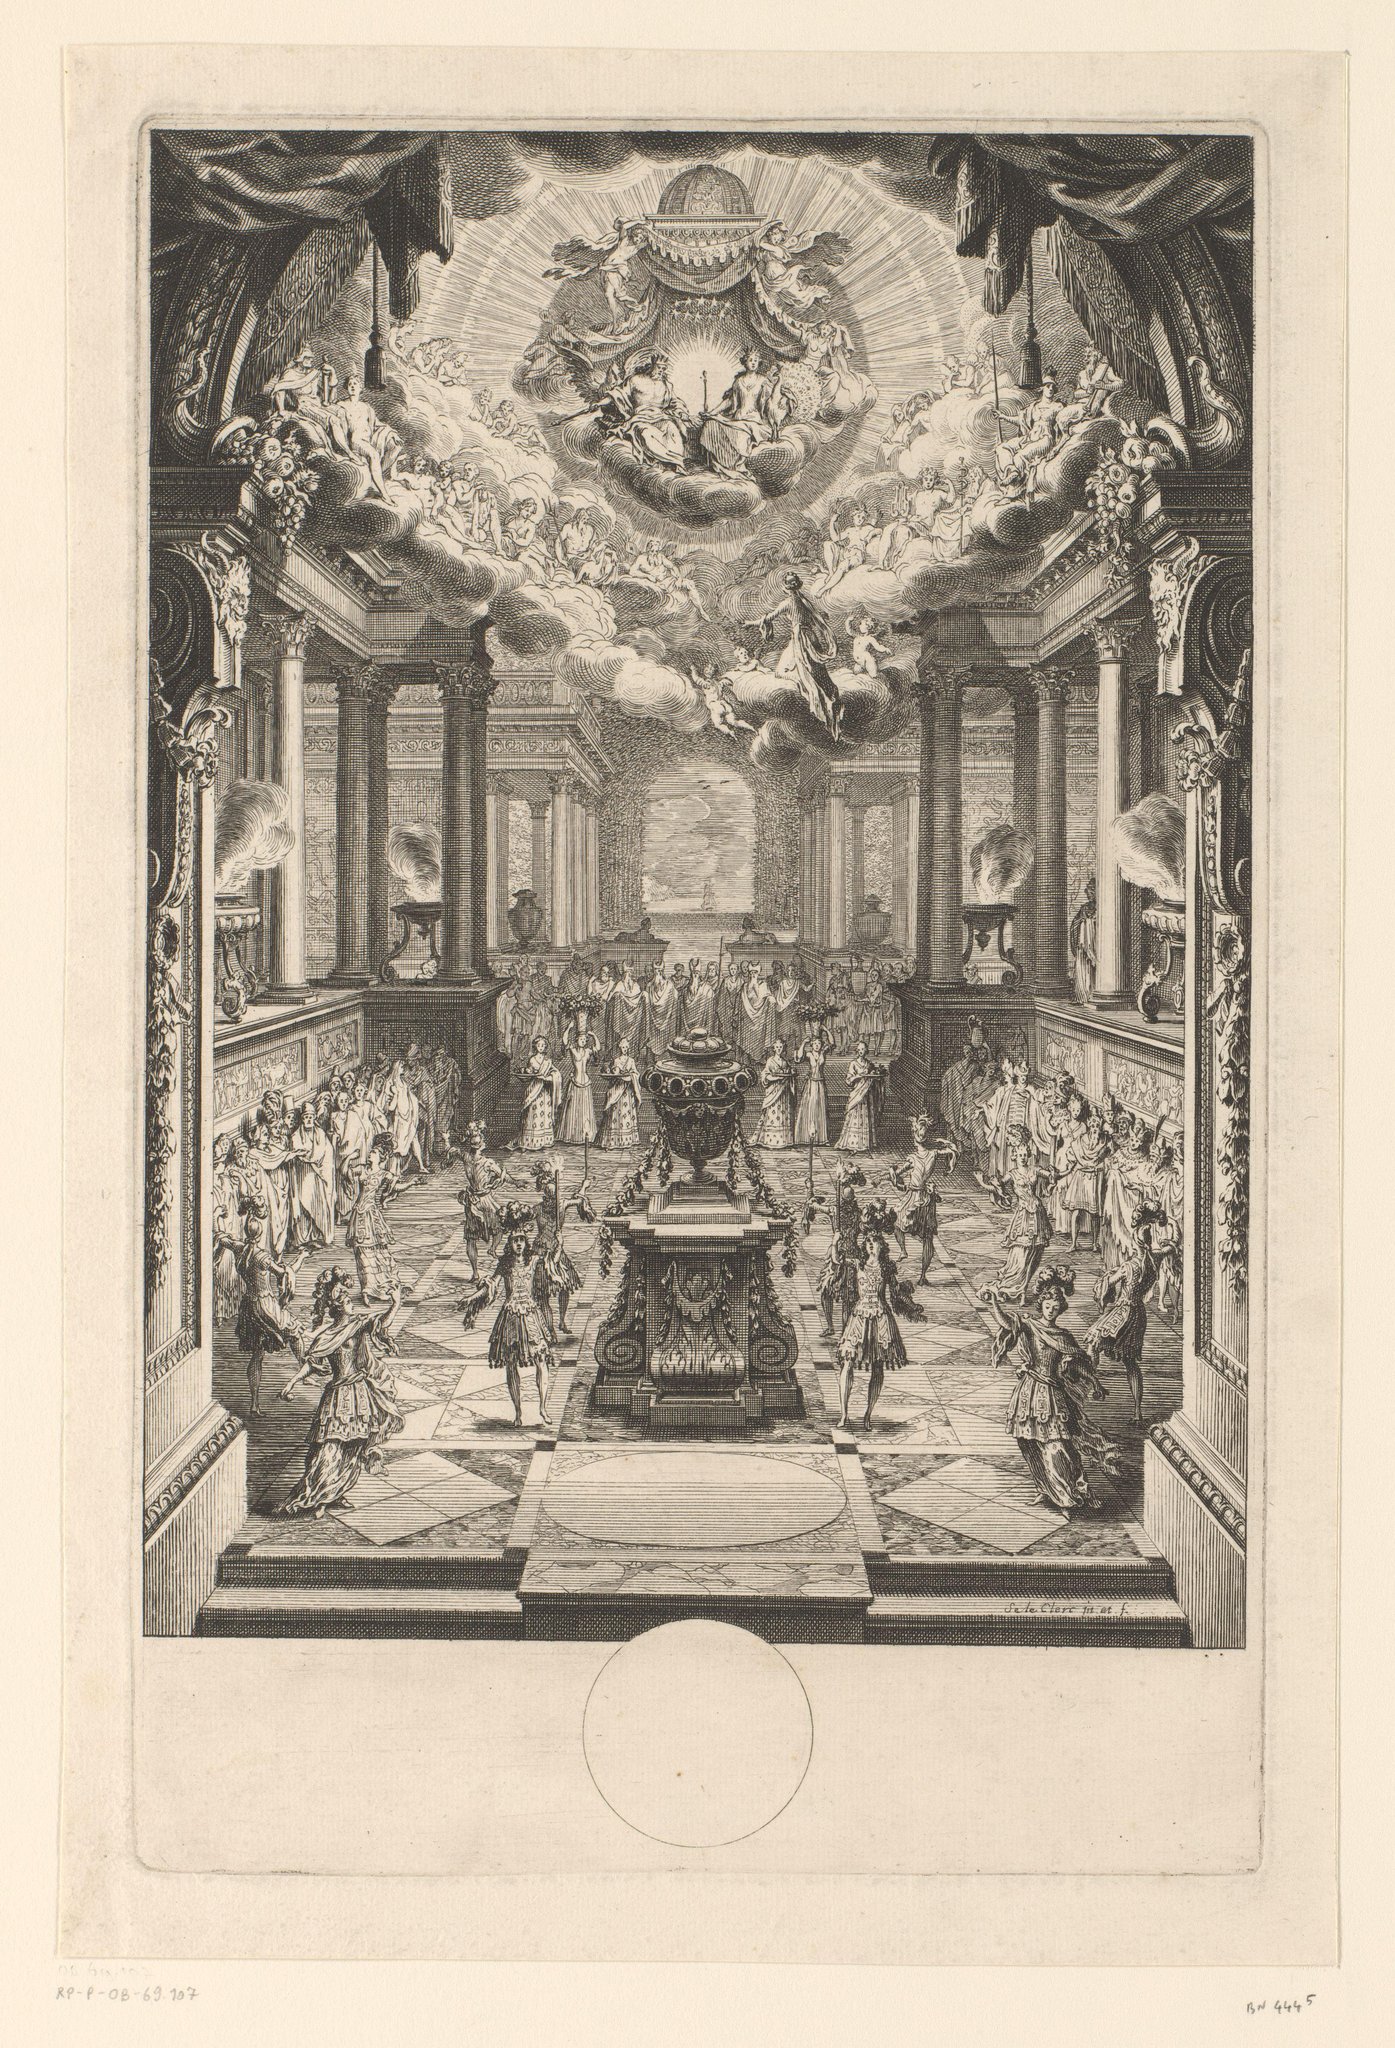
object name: print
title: Apotheose van Isis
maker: sébastien leclerc (i)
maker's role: print maker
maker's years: 1637-1714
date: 1693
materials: paper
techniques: engraving, etching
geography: france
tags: suffering, misfortune of isis - apotheosis, deification of non-christian god or goddess